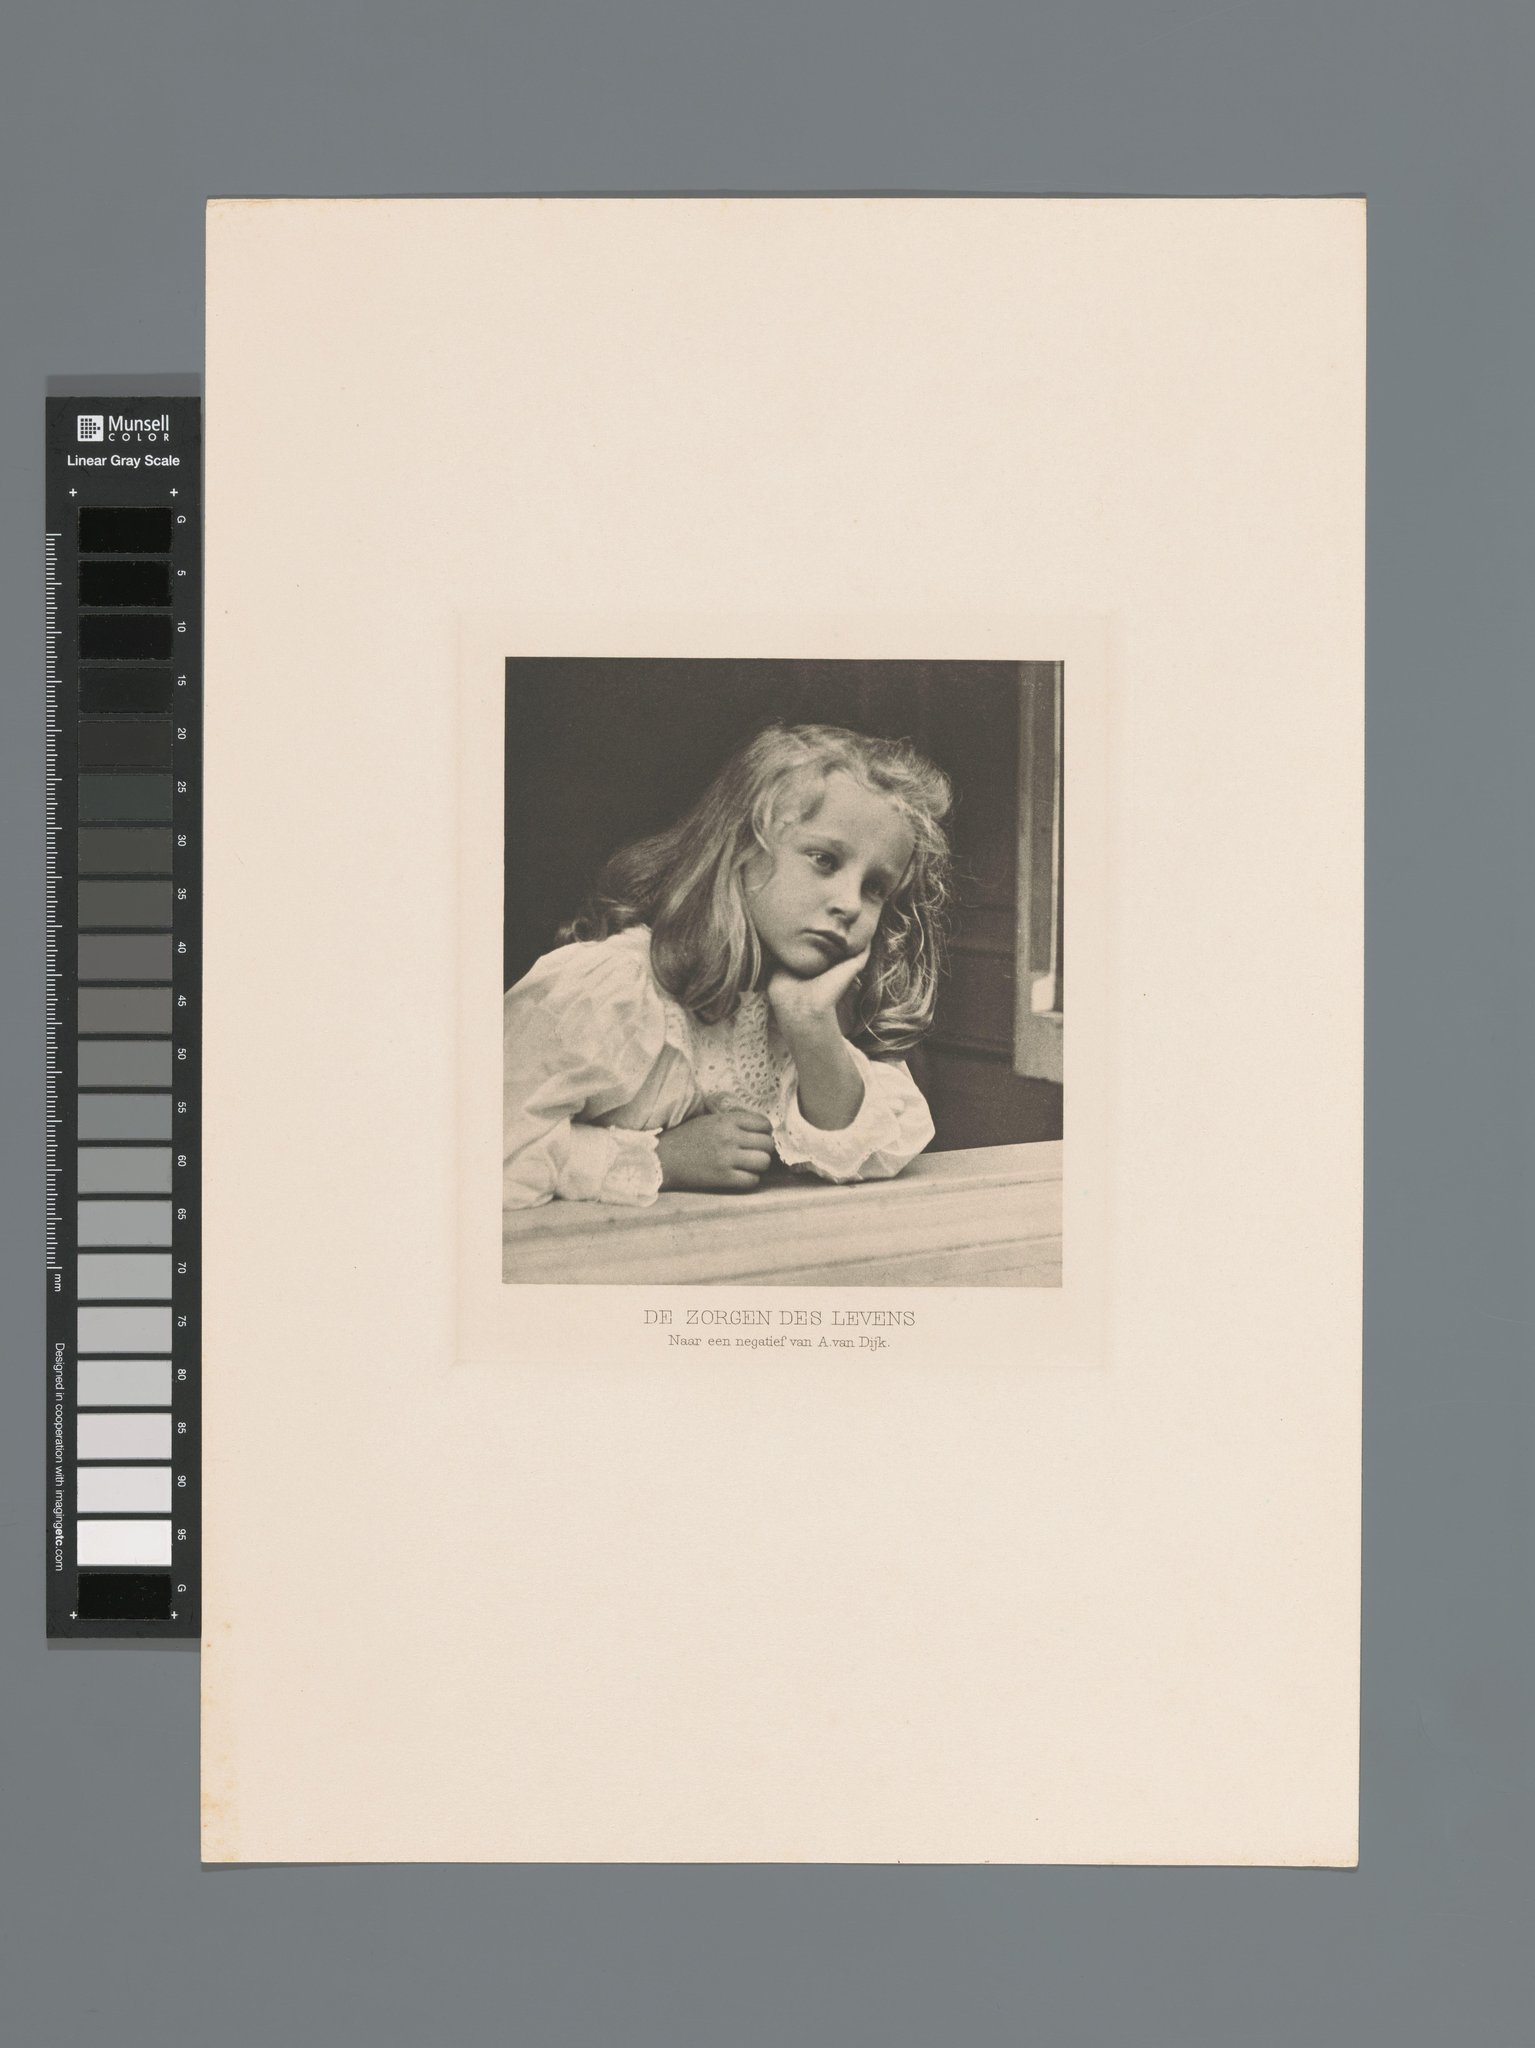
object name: photomechanical print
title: Peinzend meisje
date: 1901-1906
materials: paper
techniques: photoaquatint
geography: netherlands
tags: child, female infant